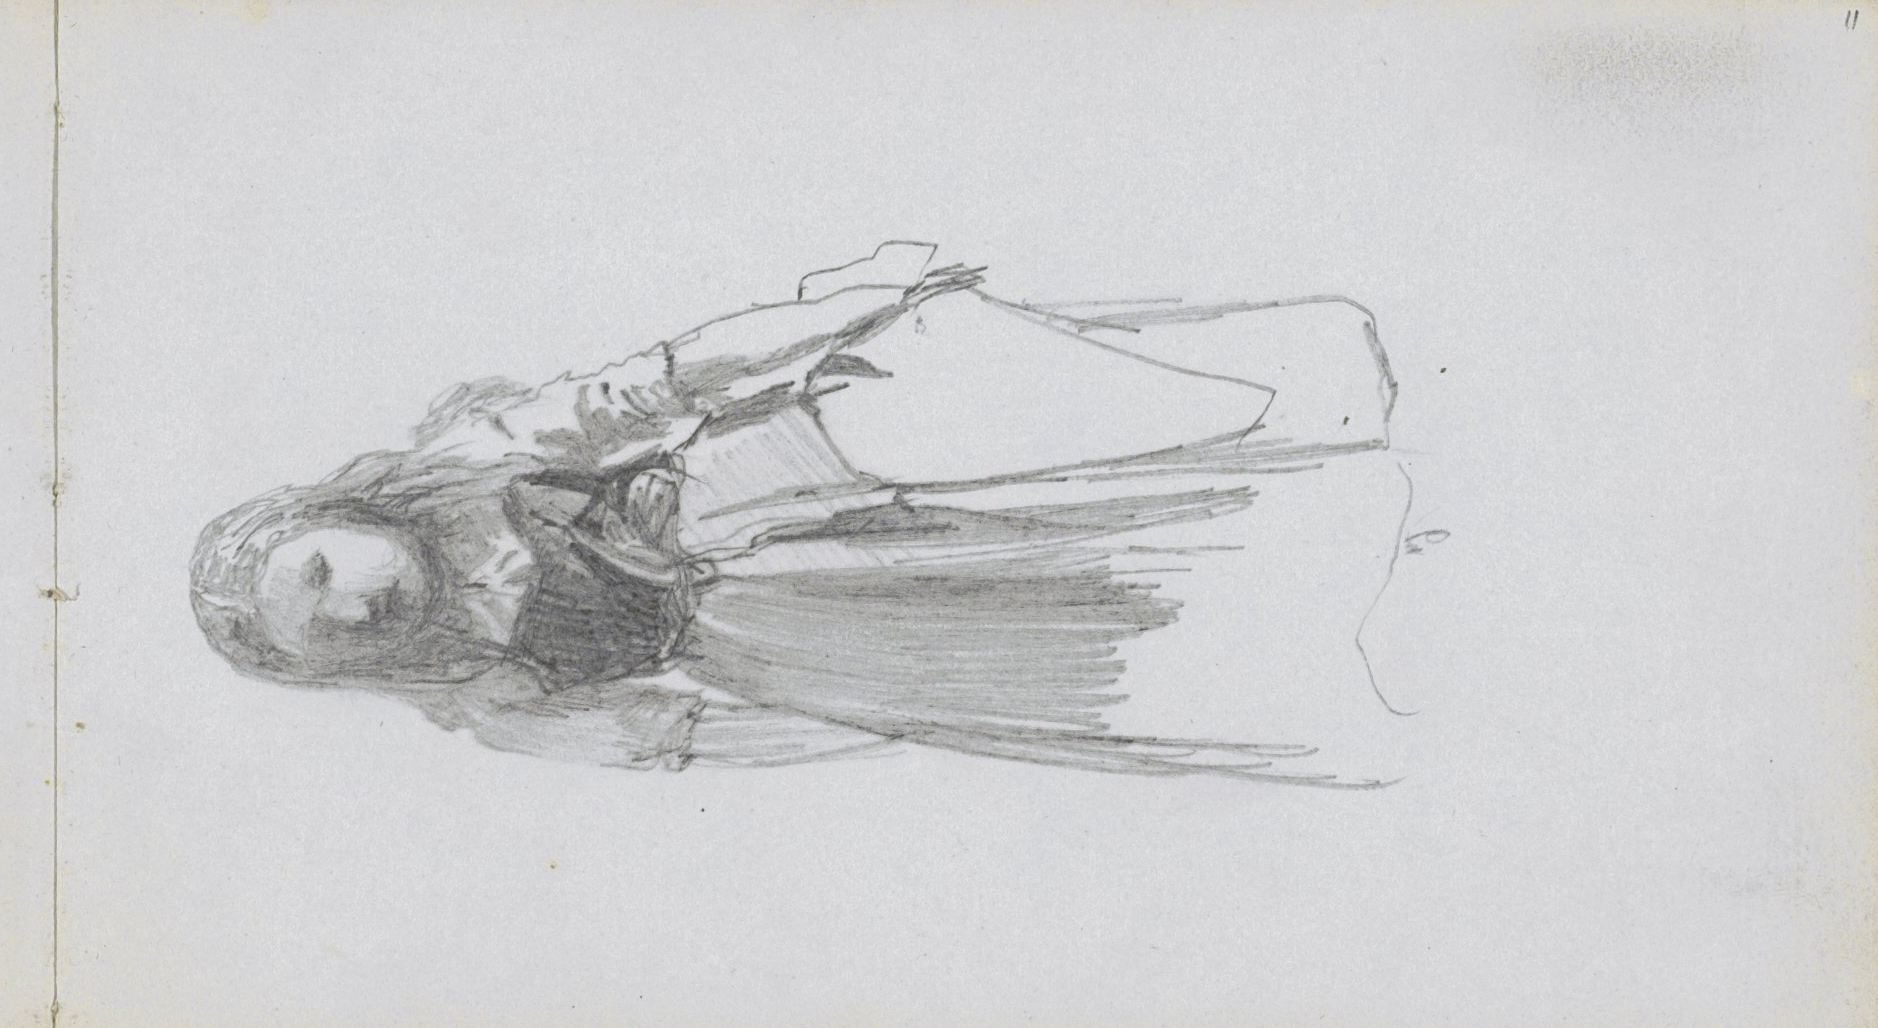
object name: sketchbook leaf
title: Staand meisje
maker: johan hendrik weissenbruch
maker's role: draughtsman, painter, print maker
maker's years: 1824-1903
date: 1834-1903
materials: paper, pencil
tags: standing figure (+ young female (human being))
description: Blad 11 recto uit een schetsboek met 39 bladen.